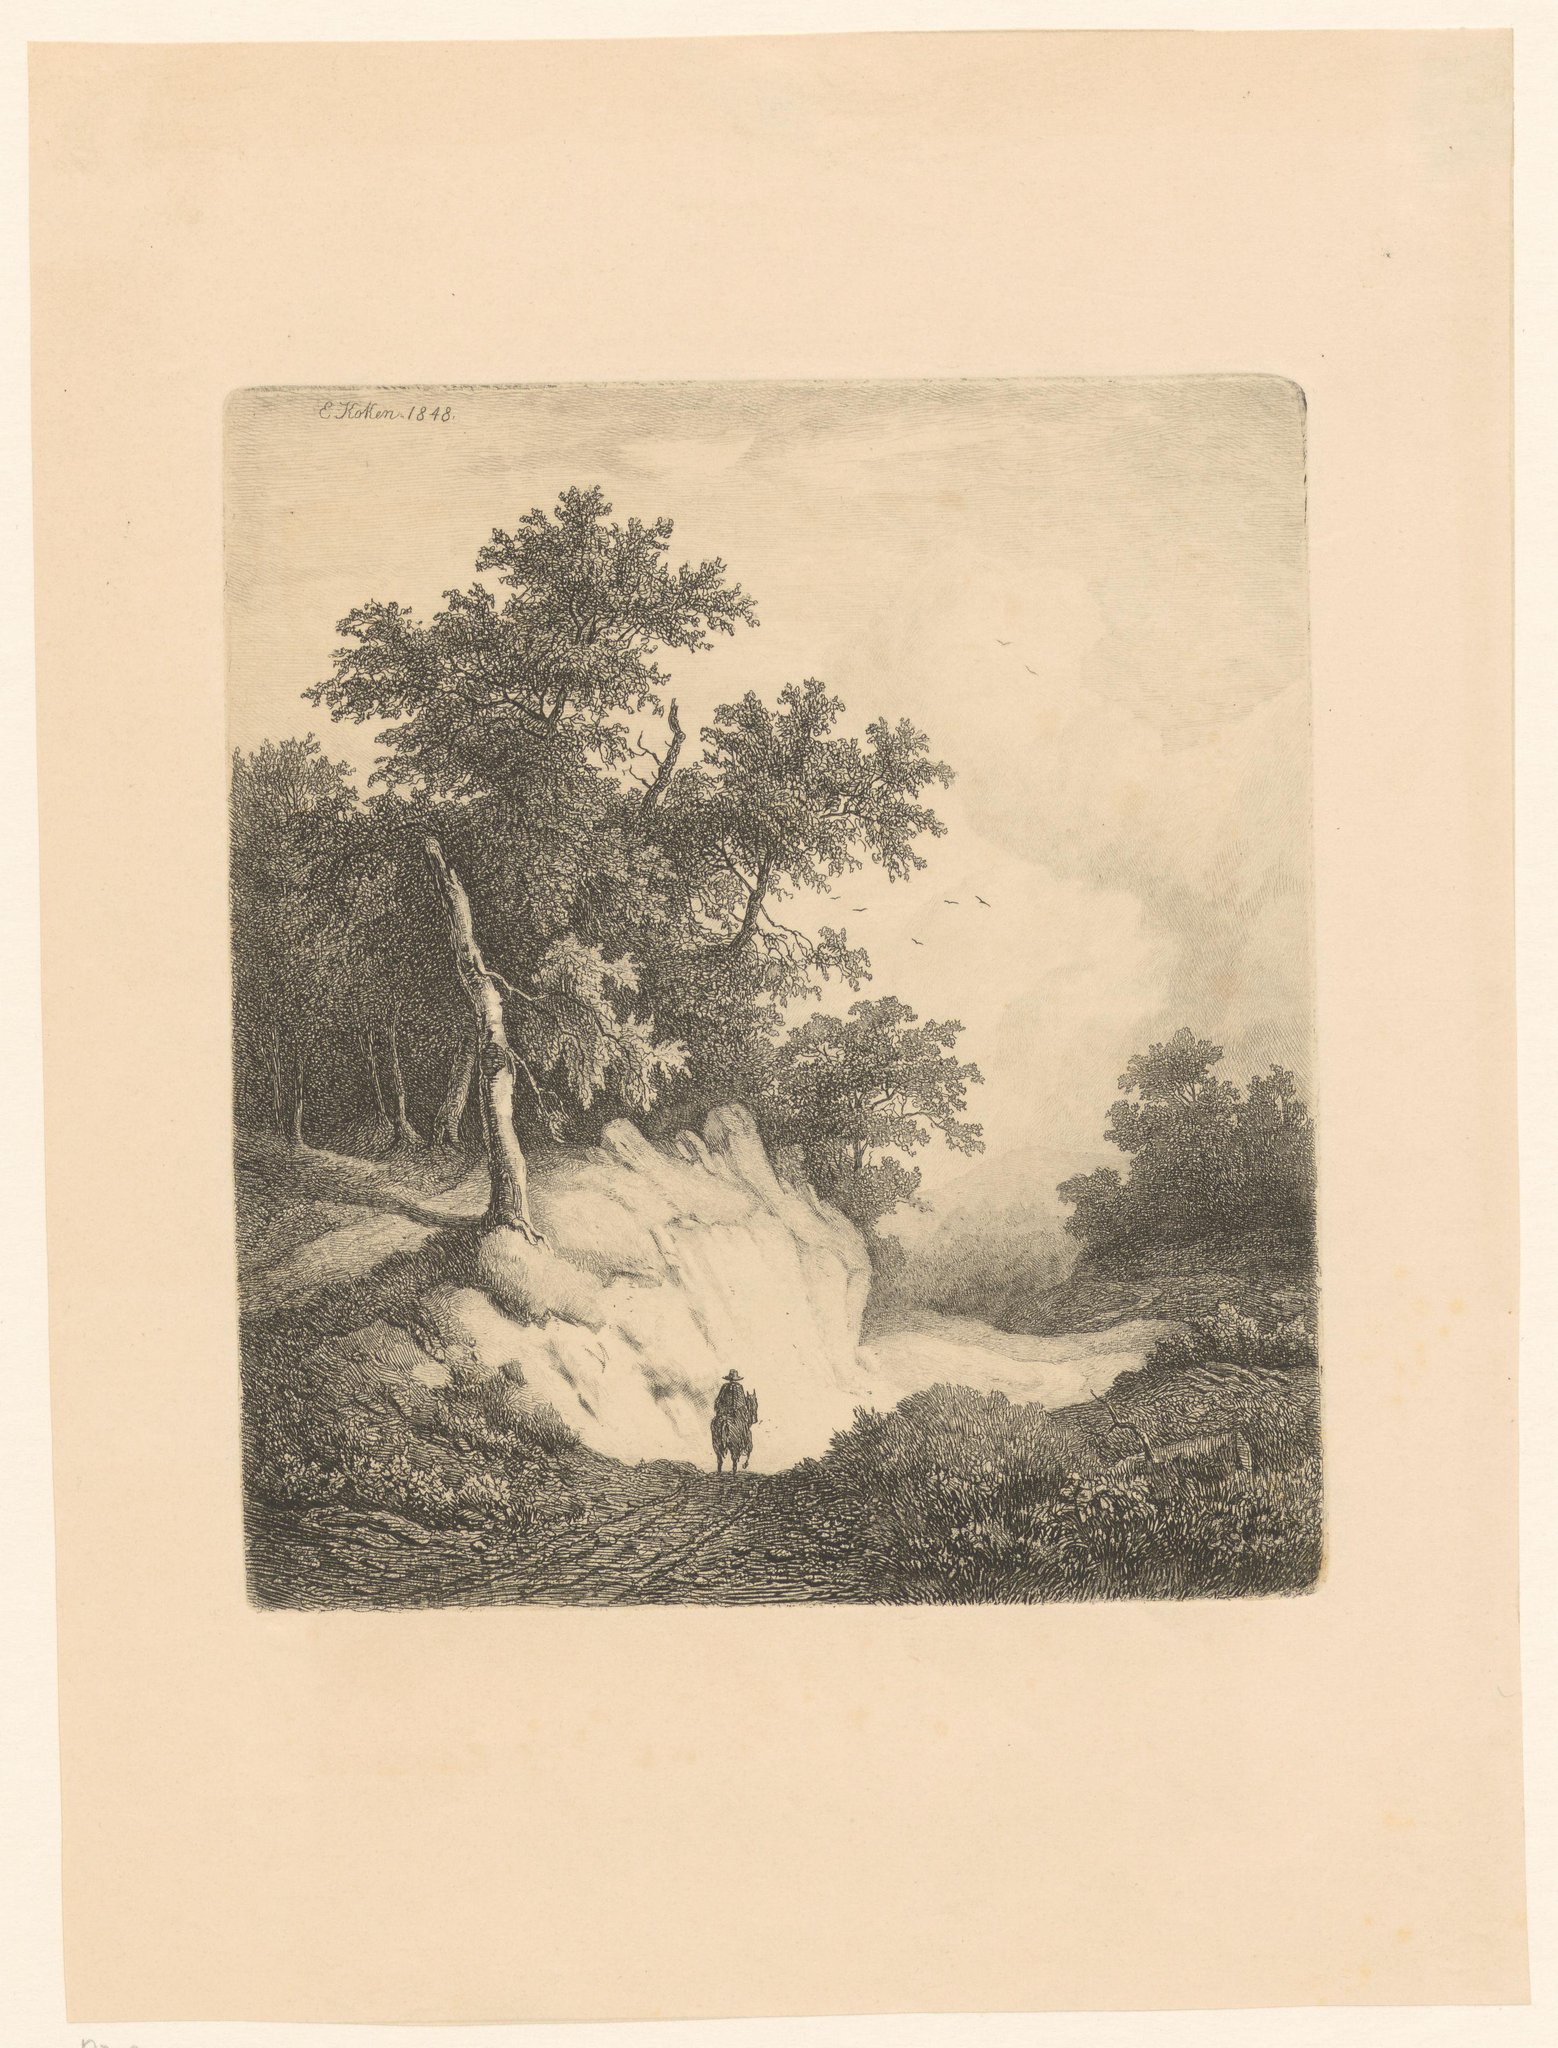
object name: print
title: Rotsachtig landschap met reiziger te paard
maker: edmund koken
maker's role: painter, print maker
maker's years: 1814-1872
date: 1848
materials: paper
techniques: engraving, etching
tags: rock-formations, 'en route', traveller under way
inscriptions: collector's mark: Lugt 2228